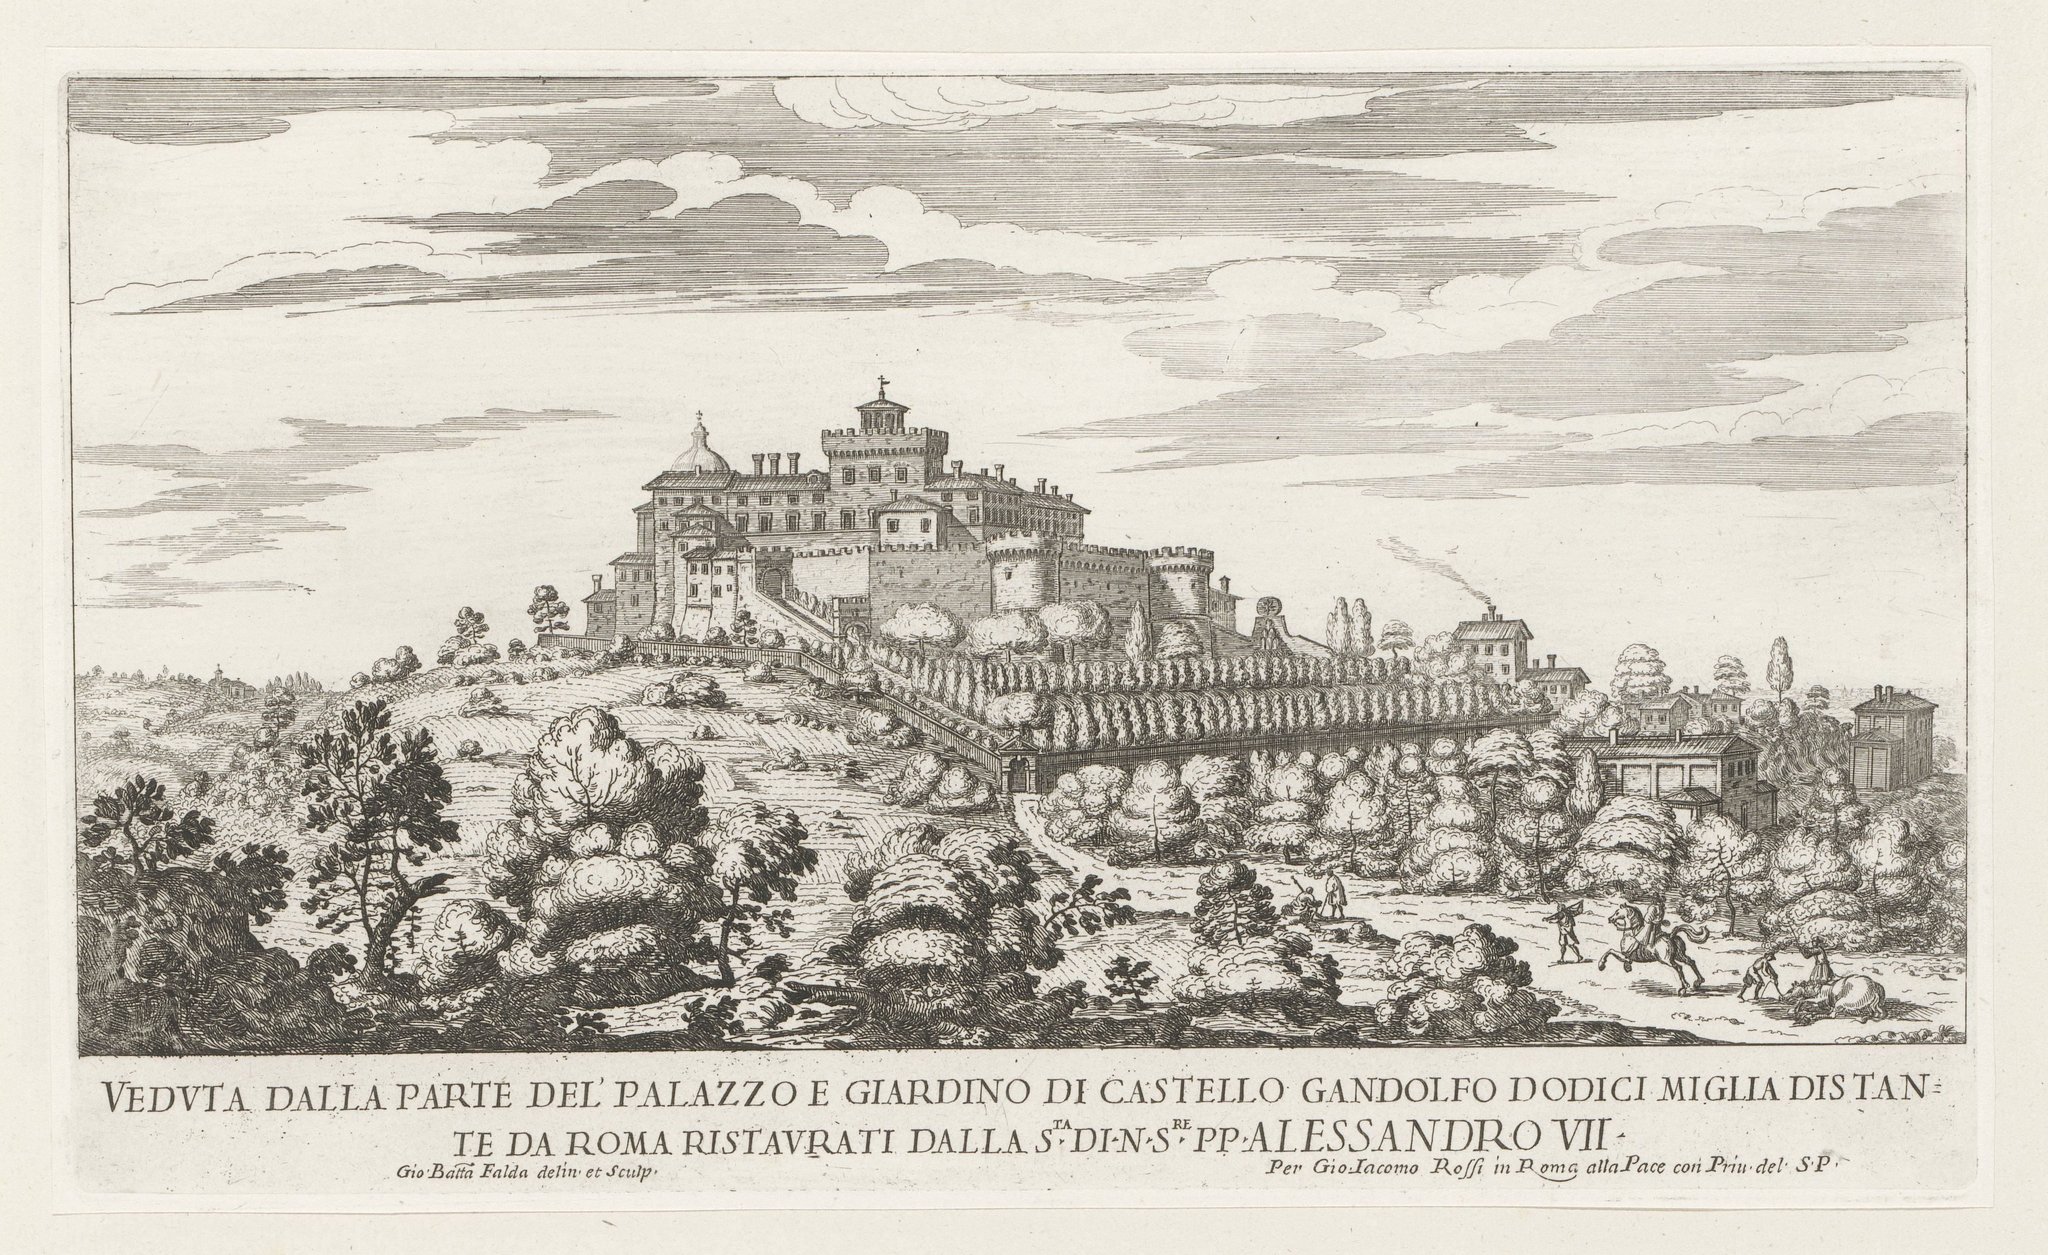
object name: album leaf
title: Il nuovo teatro di Roma Moderna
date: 1665-1667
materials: paper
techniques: etching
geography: rome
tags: city-view, and landscape with man-made constructions, garden, palace, street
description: Deze prent maakt deel uit van een reeks bestaande uit vijf delen, waarvan de eerste drie delen bestaan uit prenten van Giovanni Battista Falda. Deel één bevat 25 prenten (+ titelprent en opdracht) (1665), deel twee bevat 15 prenten (+ titelprent en opdracht) (1665-67) en deel drie bevat 38 prenten (+ titelprent en opdracht) (1669-70). Delen vier en vijf bevatten prenten door Alessandro Specchi en Giovanni Domenico Campiglia. De originele drukplaten voor de eerste drie delen worden bewaard in de Calcografia Nazionale in Rome (inv. nr. 1414).